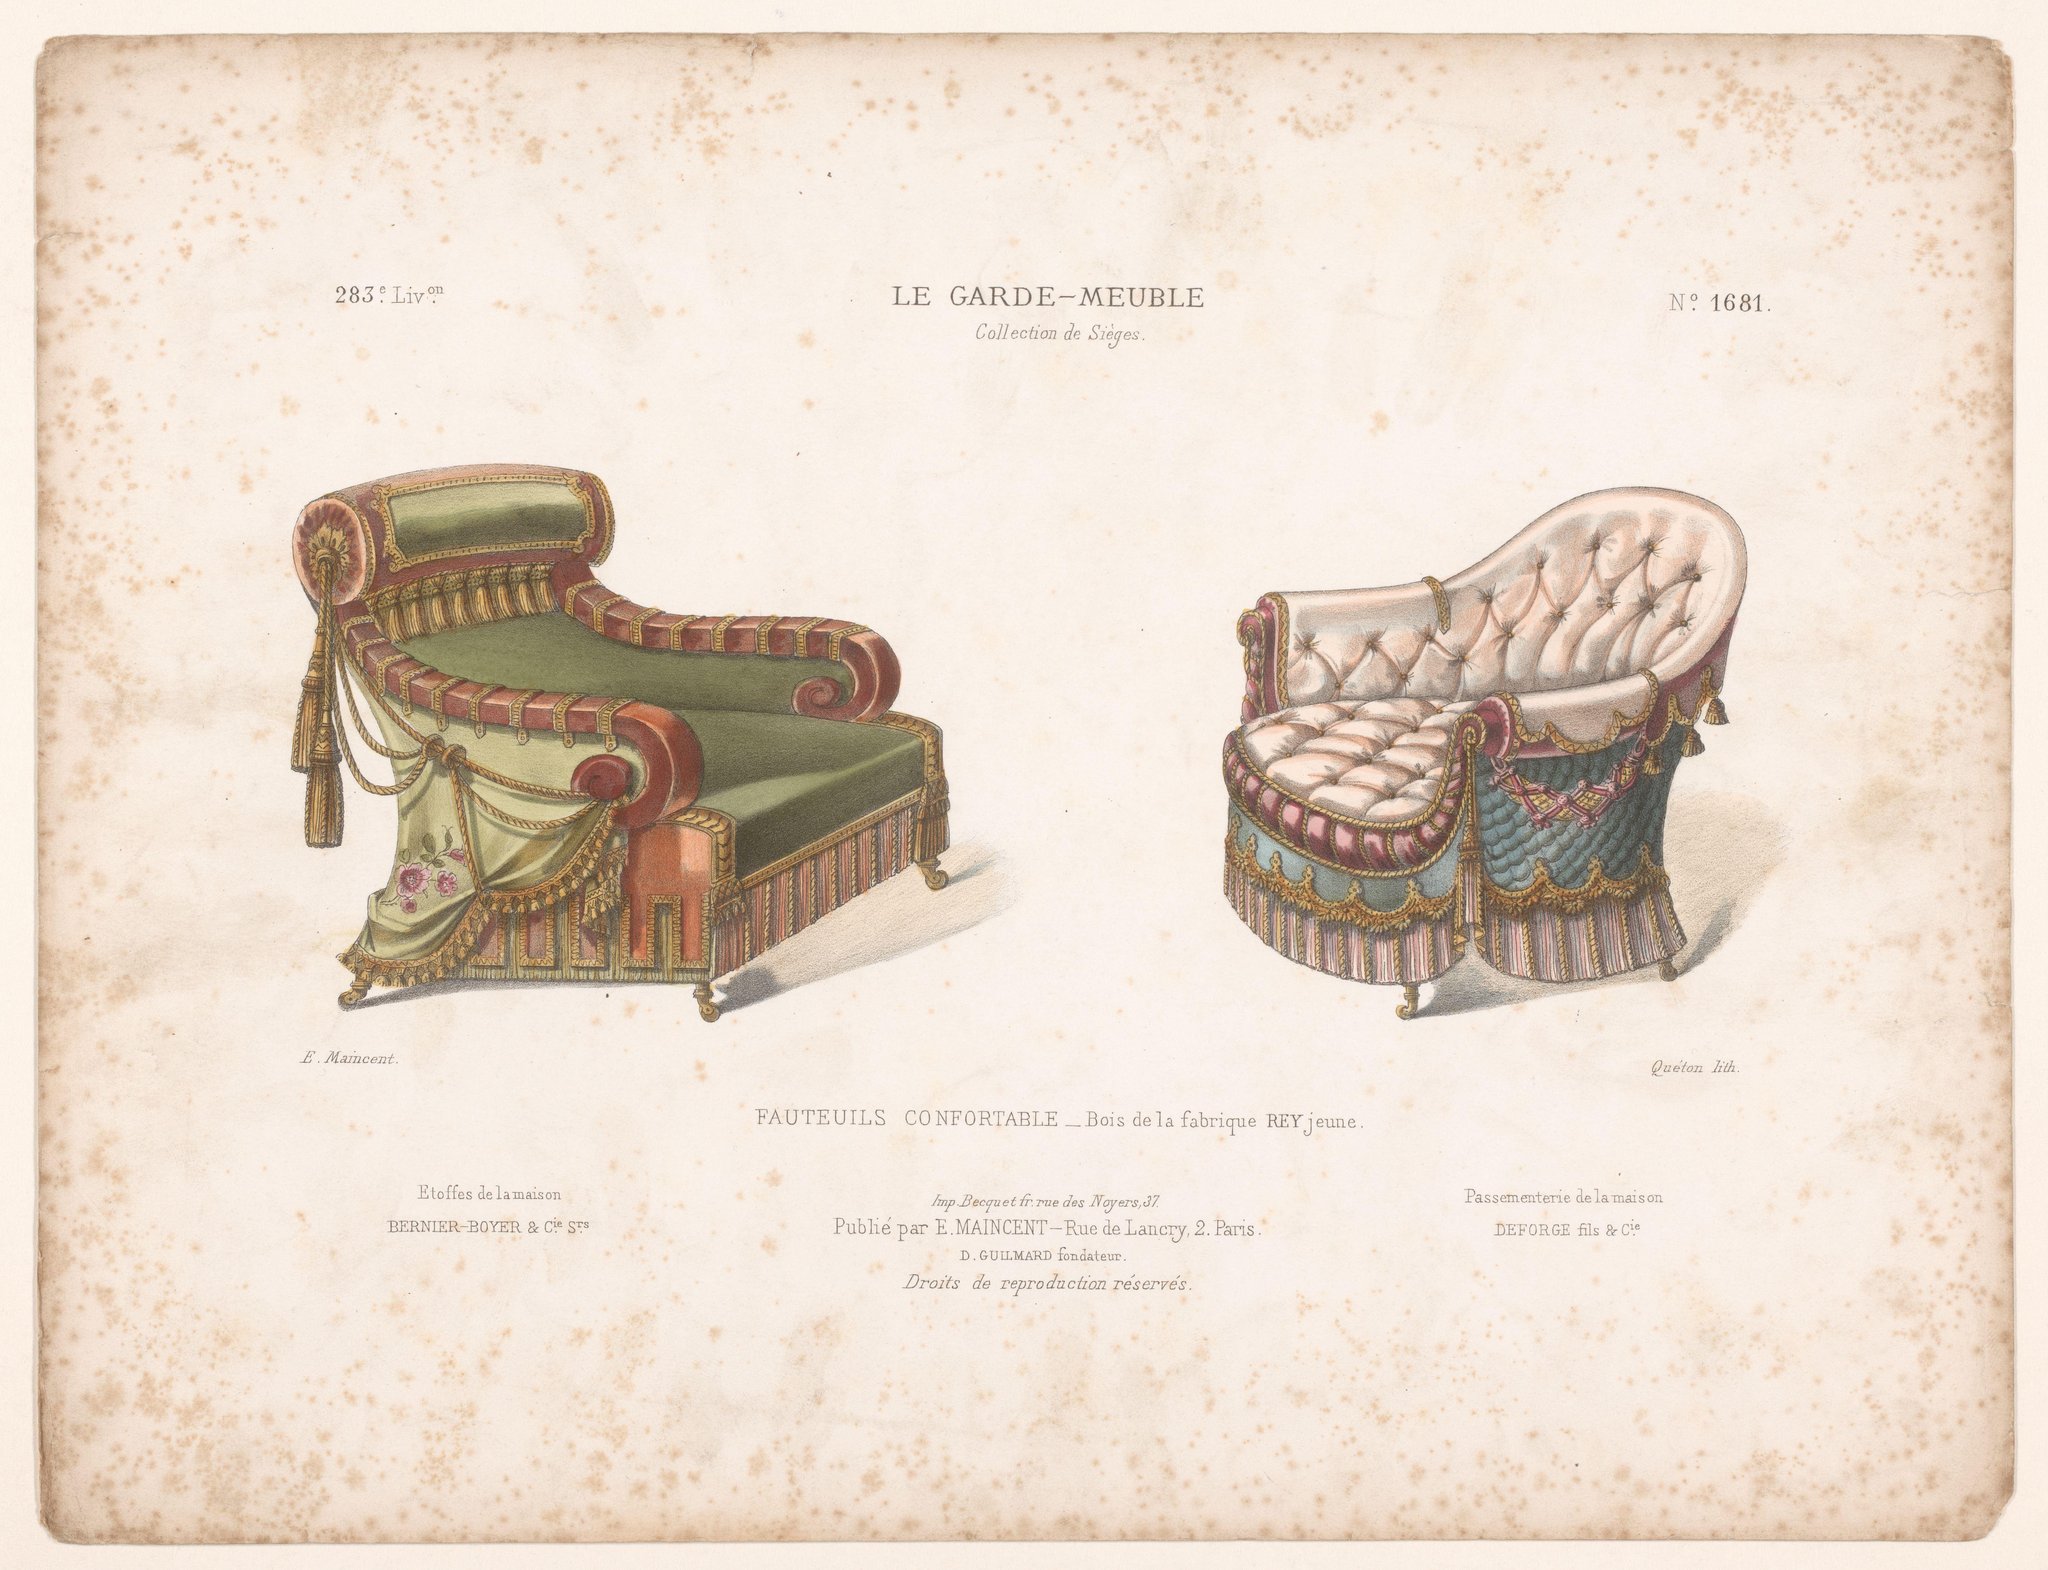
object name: print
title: Le garde-meuble / Collection de Sièges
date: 1885-1895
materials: paper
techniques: hand coloring, lithograph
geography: paris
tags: seating furniture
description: Ieder Livraison in de serie Le Garde-Meuble bevat negen platen: drie 'sièges' (zitmeubels), drie 'meubles' (diverse meubels zoals tafels en kasten) en drie 'tentures' (gordijnen en draperieën).